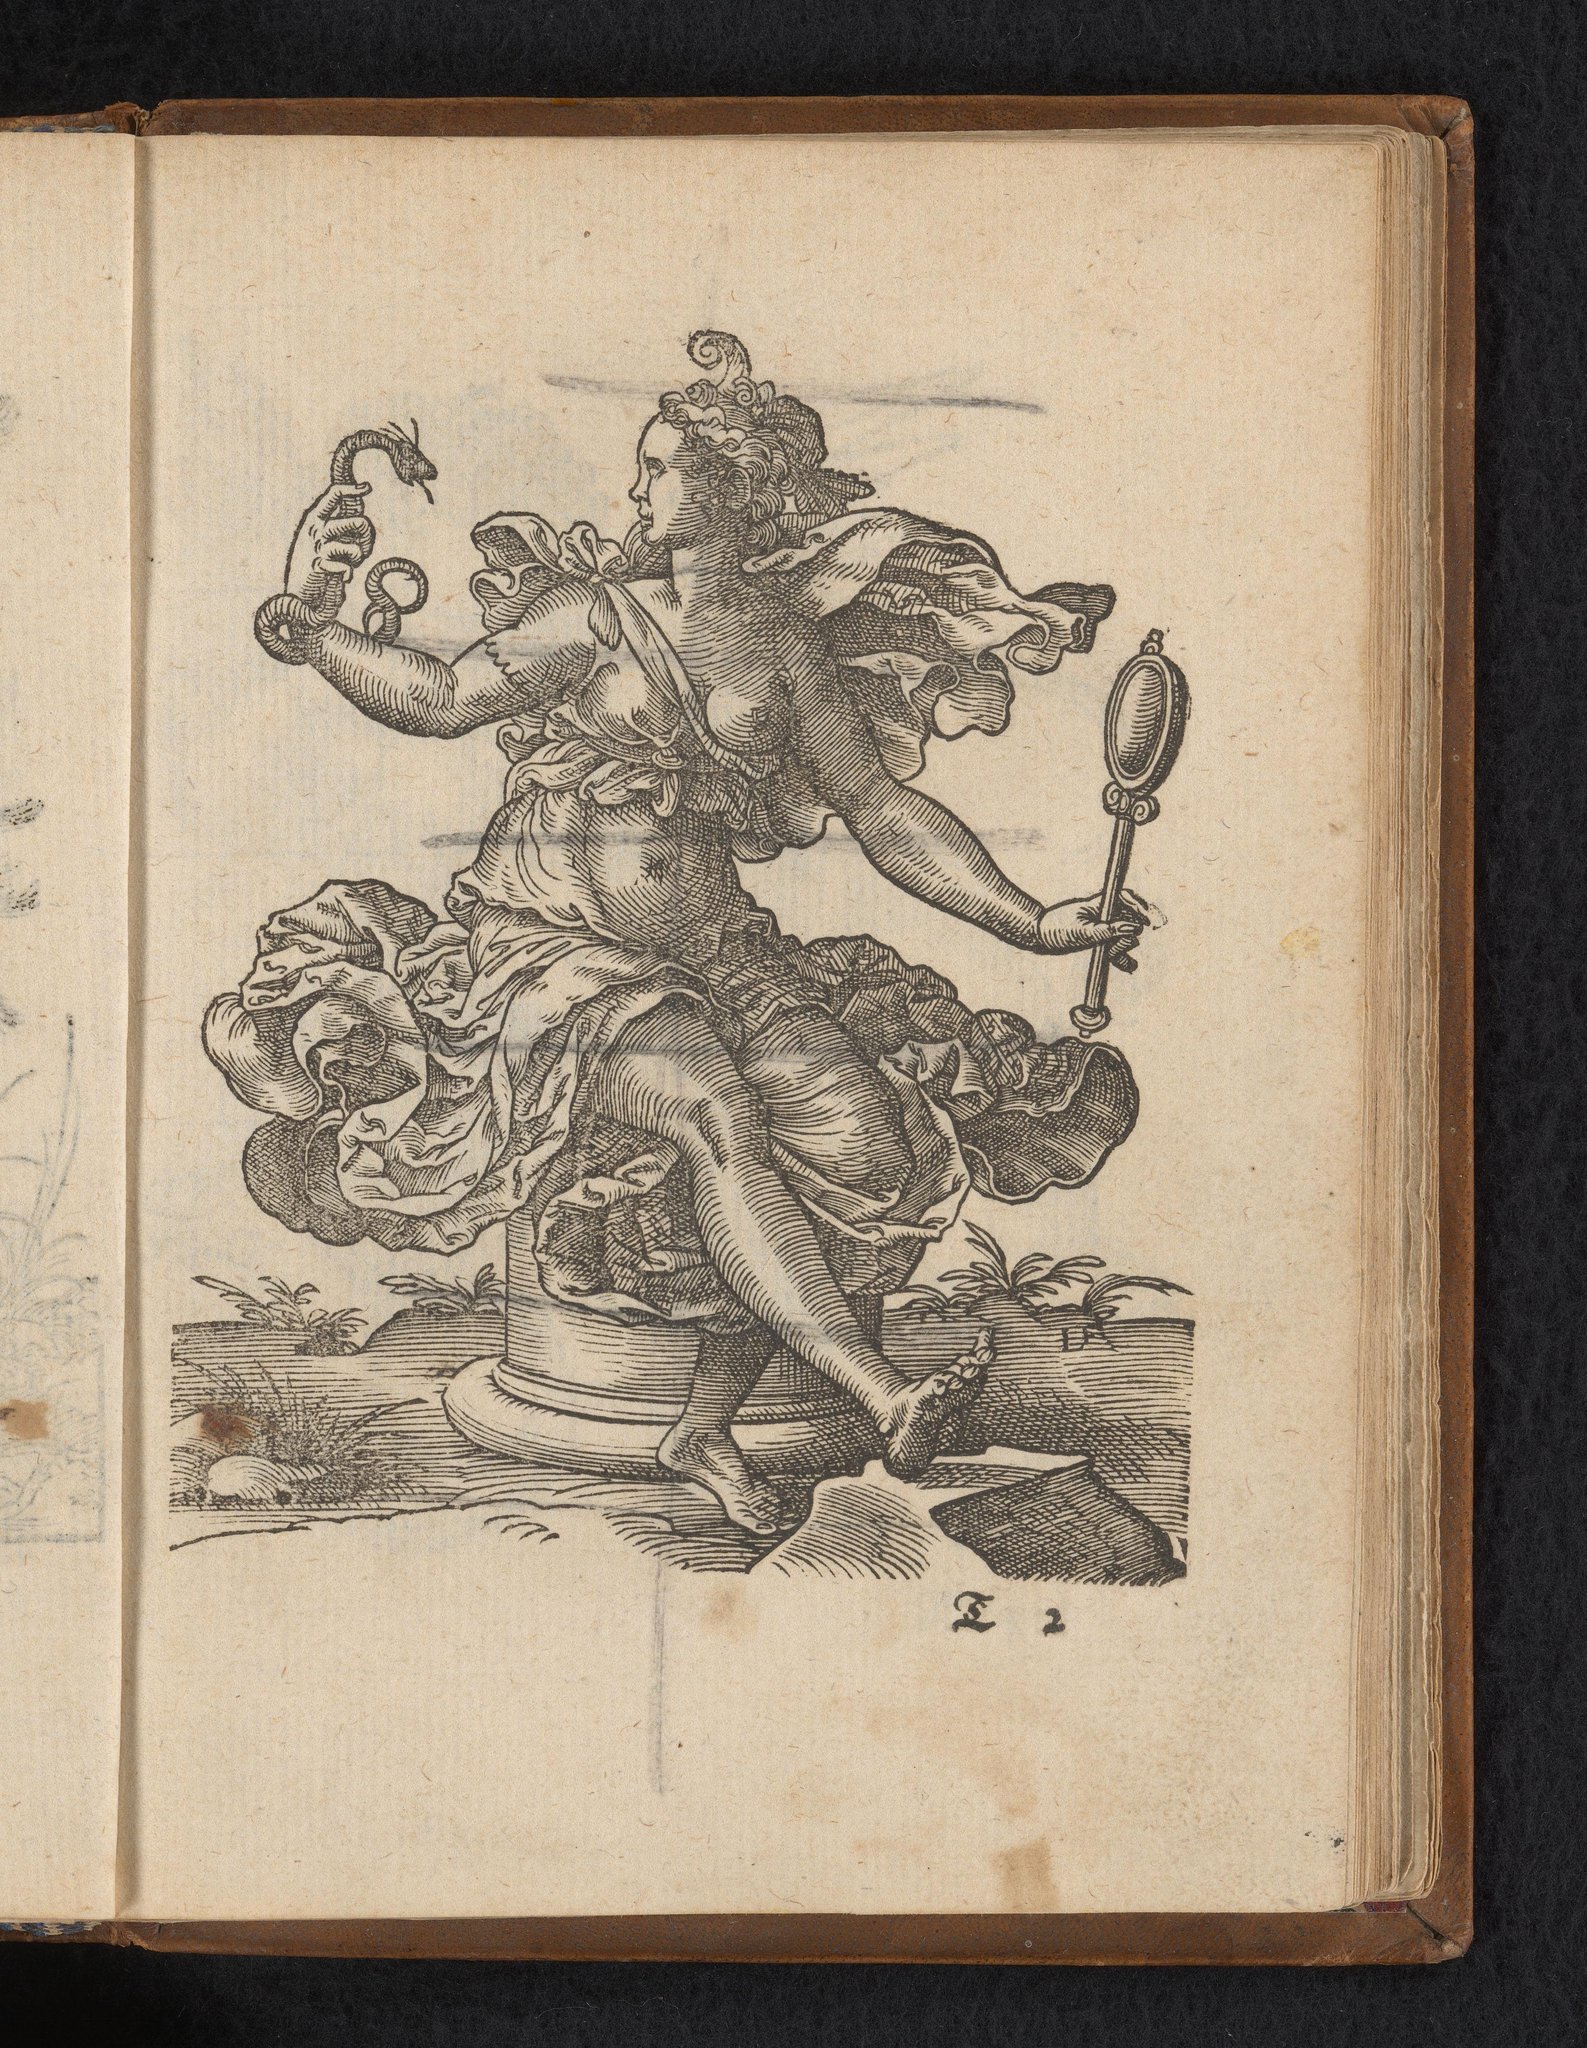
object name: print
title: Prudentia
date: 1578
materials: paper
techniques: woodcut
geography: nuremberg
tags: prudence, 'prudentia'; 'prudenza' (ripa) ~ one of the four cardinal virtues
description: Prudentia, de Voorzichtigheid. Onderdeel van het modelboek Enchiridion artis pingendi, fingendi & sculpendi met 108 figuren bedoeld voor beginnende schilders, beeldhouwers en prentmakers.